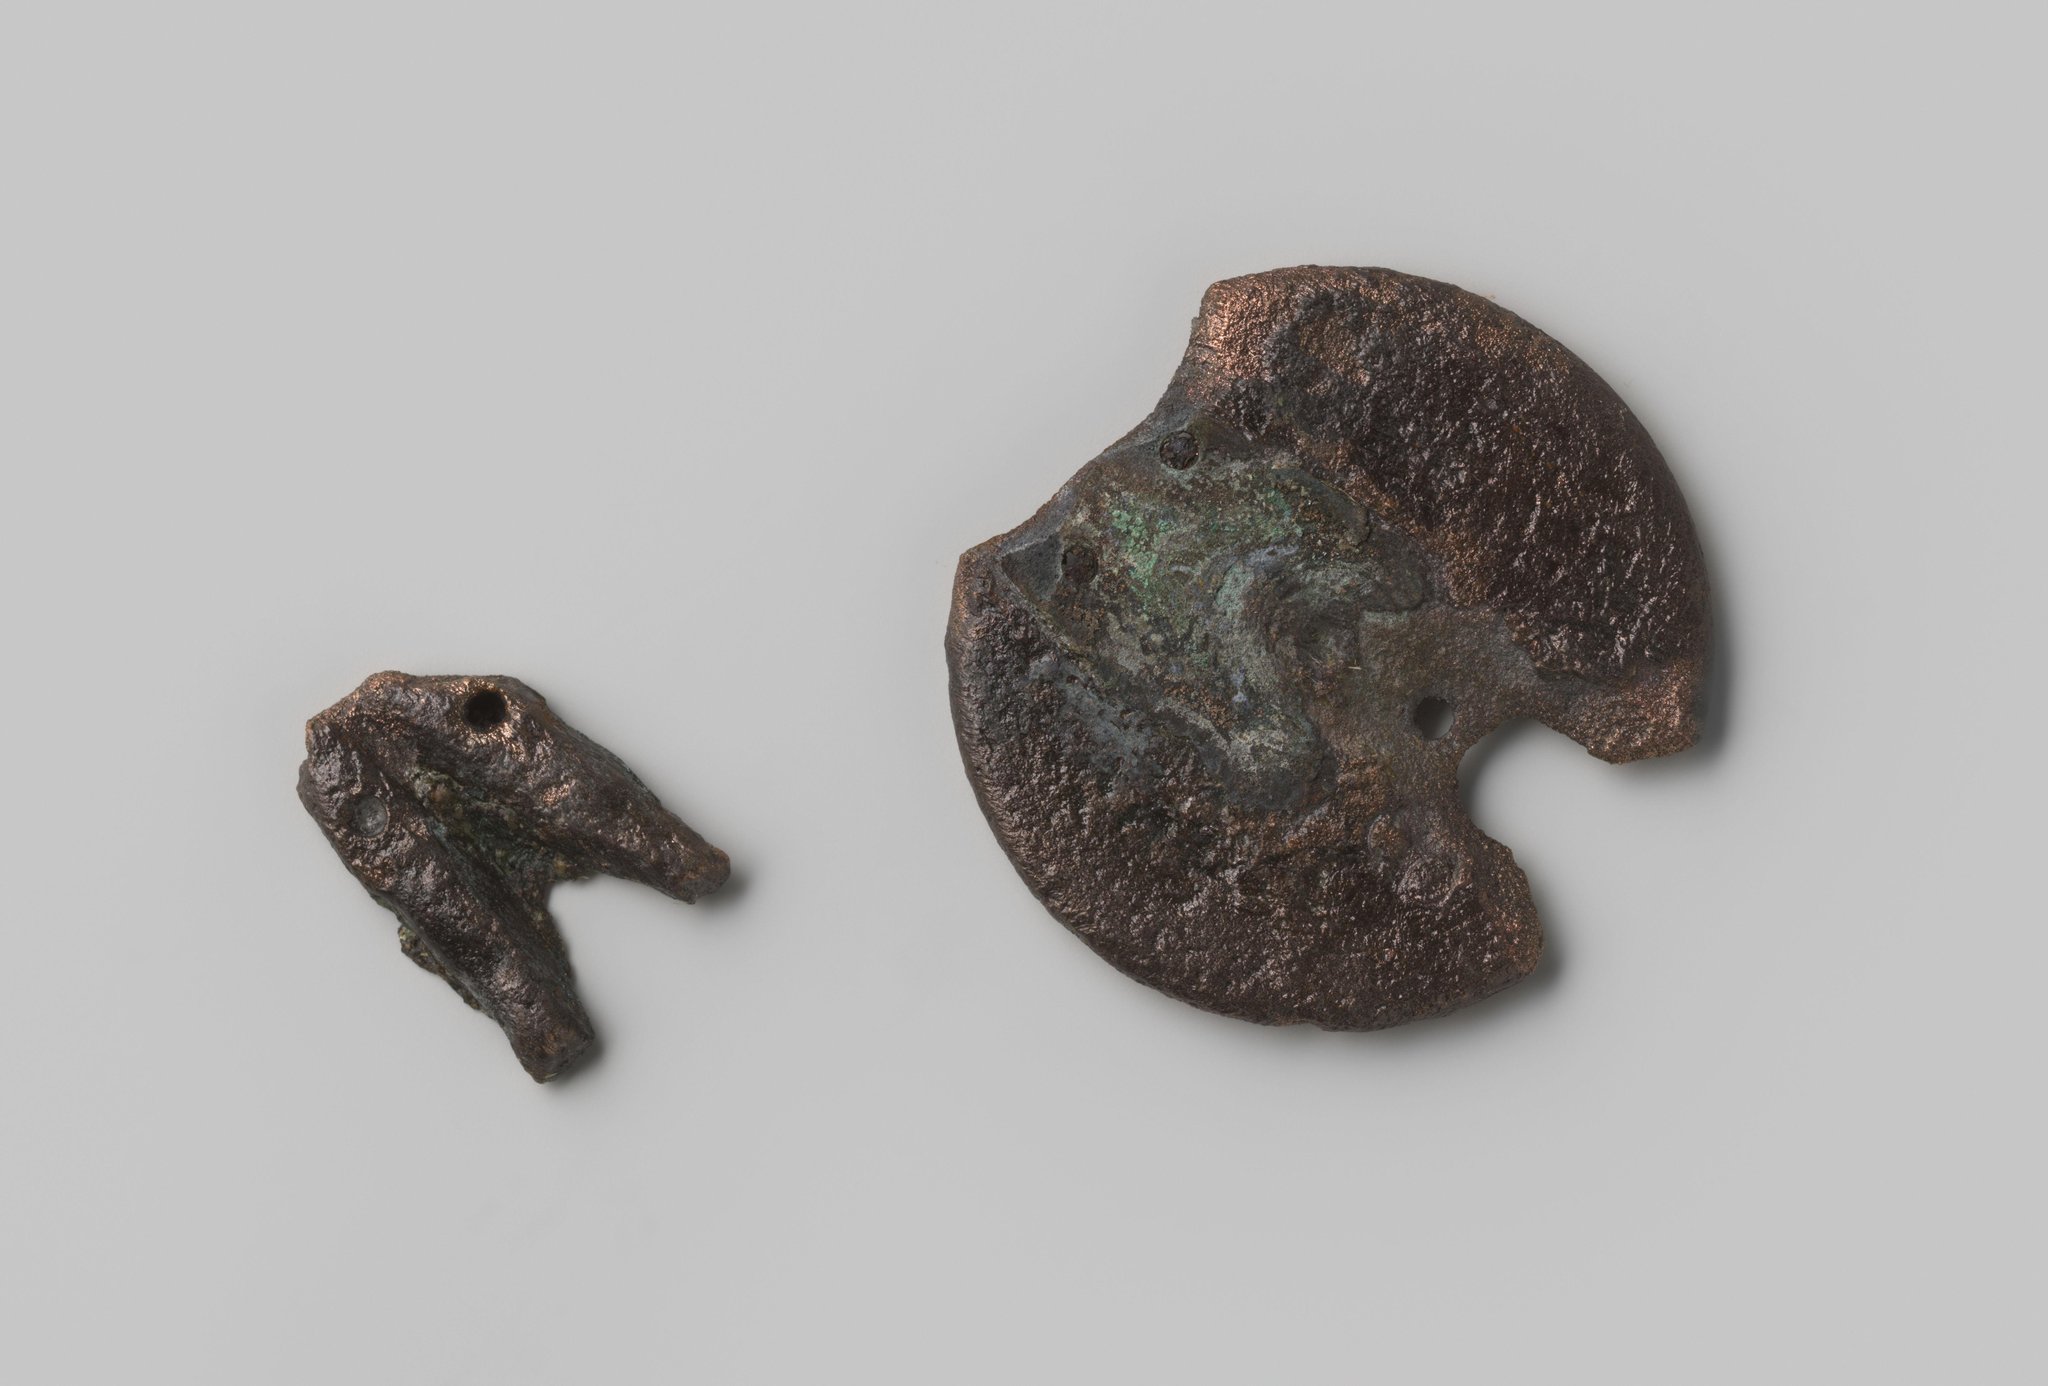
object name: lid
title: Deksel en scharnier van een sluitgewicht uit het wrak van de Oost-Indiëvaarder Hollandia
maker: Anonymous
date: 1700-1743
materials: copper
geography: netherlands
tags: verenigde oostindische compagnie, hollandia (schip), annet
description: Weight, cupweight, lid; id. NG 1980-27H33, with hinge fitting (cf. NG 1980-27H84), corroded, 2 marks id. NG 1980-27H2892 legible [8, fleur-de-lys].